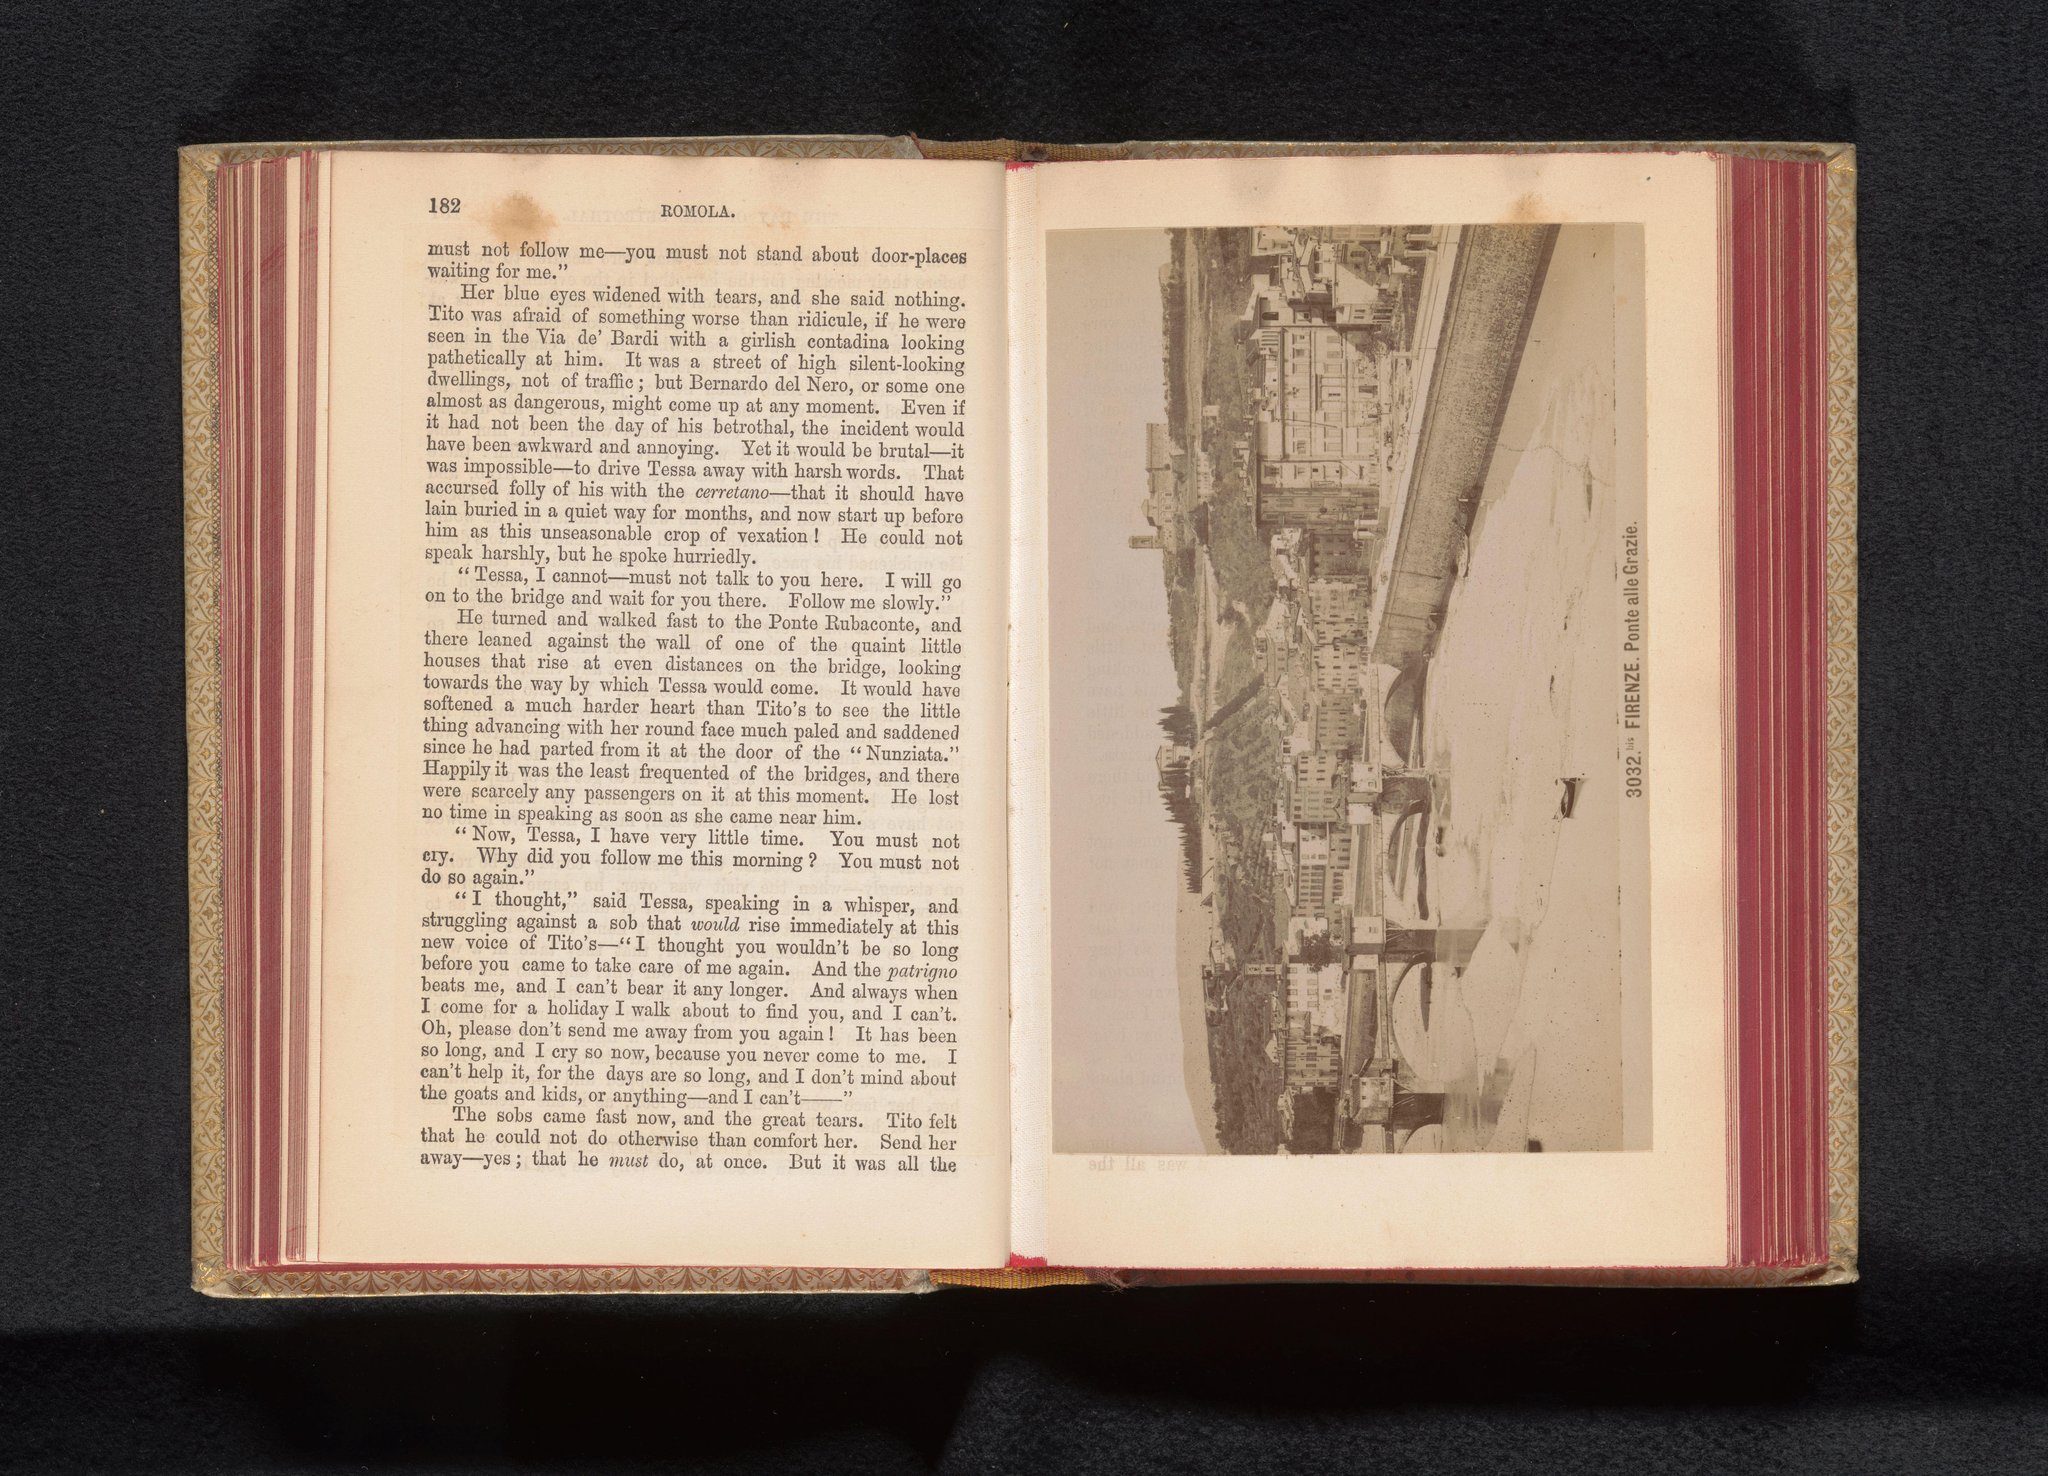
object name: photograph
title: Gezicht op de Ponte alle Grazie te Florence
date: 1878-1888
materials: photographic support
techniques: albumen print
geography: florence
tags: bridge in city across river, canal, etc.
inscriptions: number: ‘3032bis.’